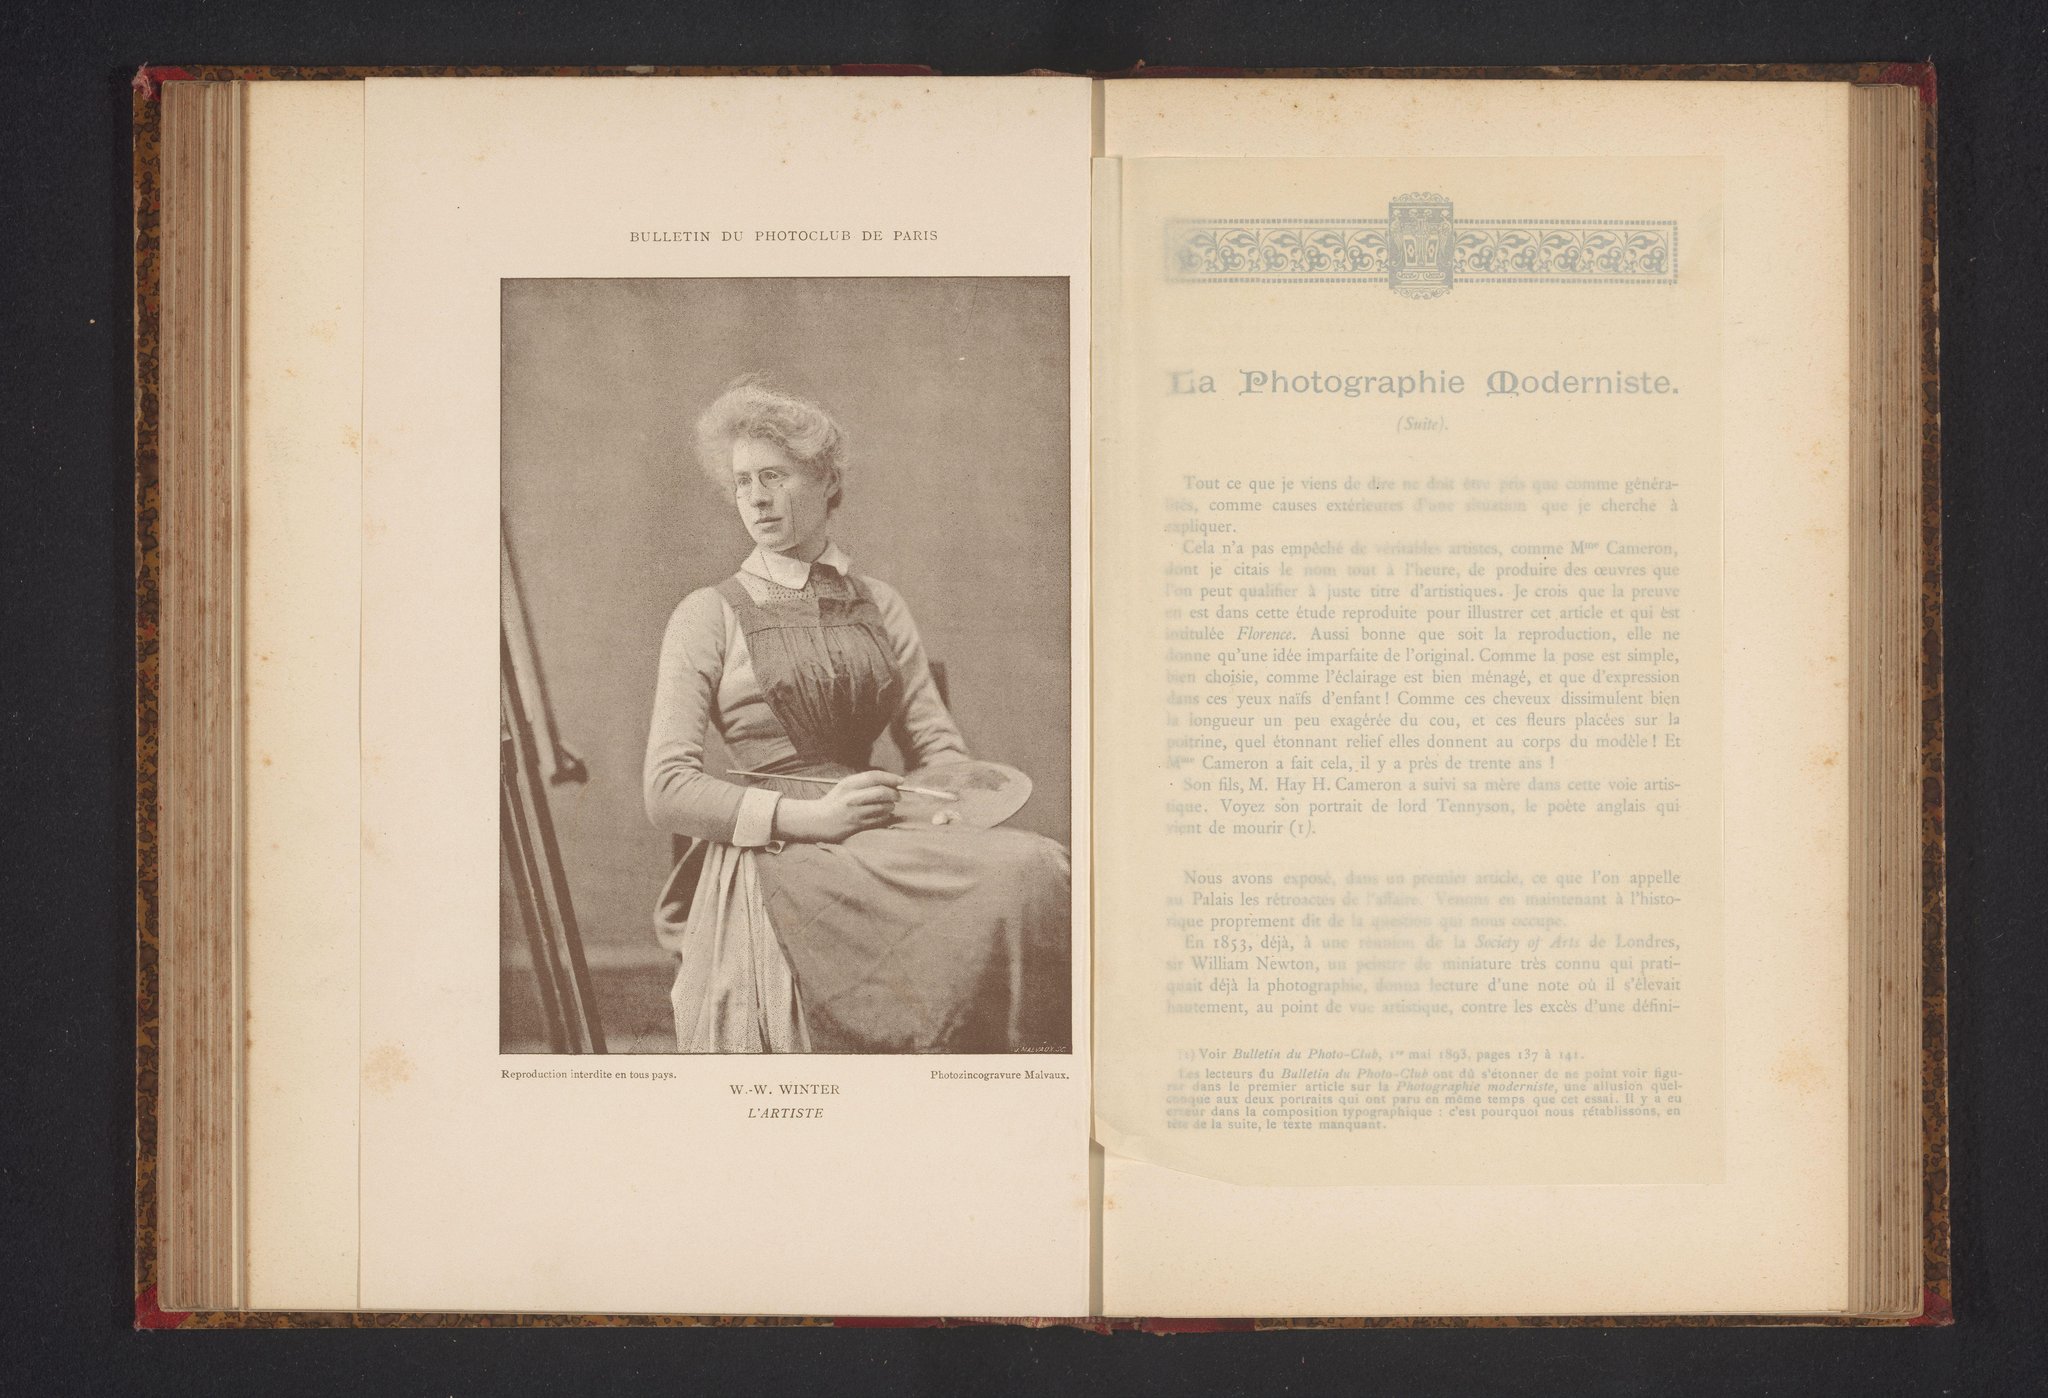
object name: page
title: Portret van een onbekende schilderes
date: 1888-1893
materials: paper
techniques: autotype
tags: historical persons not known by name - bb - woman, portrait, self-portrait of painter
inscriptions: inscription: ‘Reproduction interdite en tous pays.’, inscription: ‘Bulletin du Photoclub de Paris’